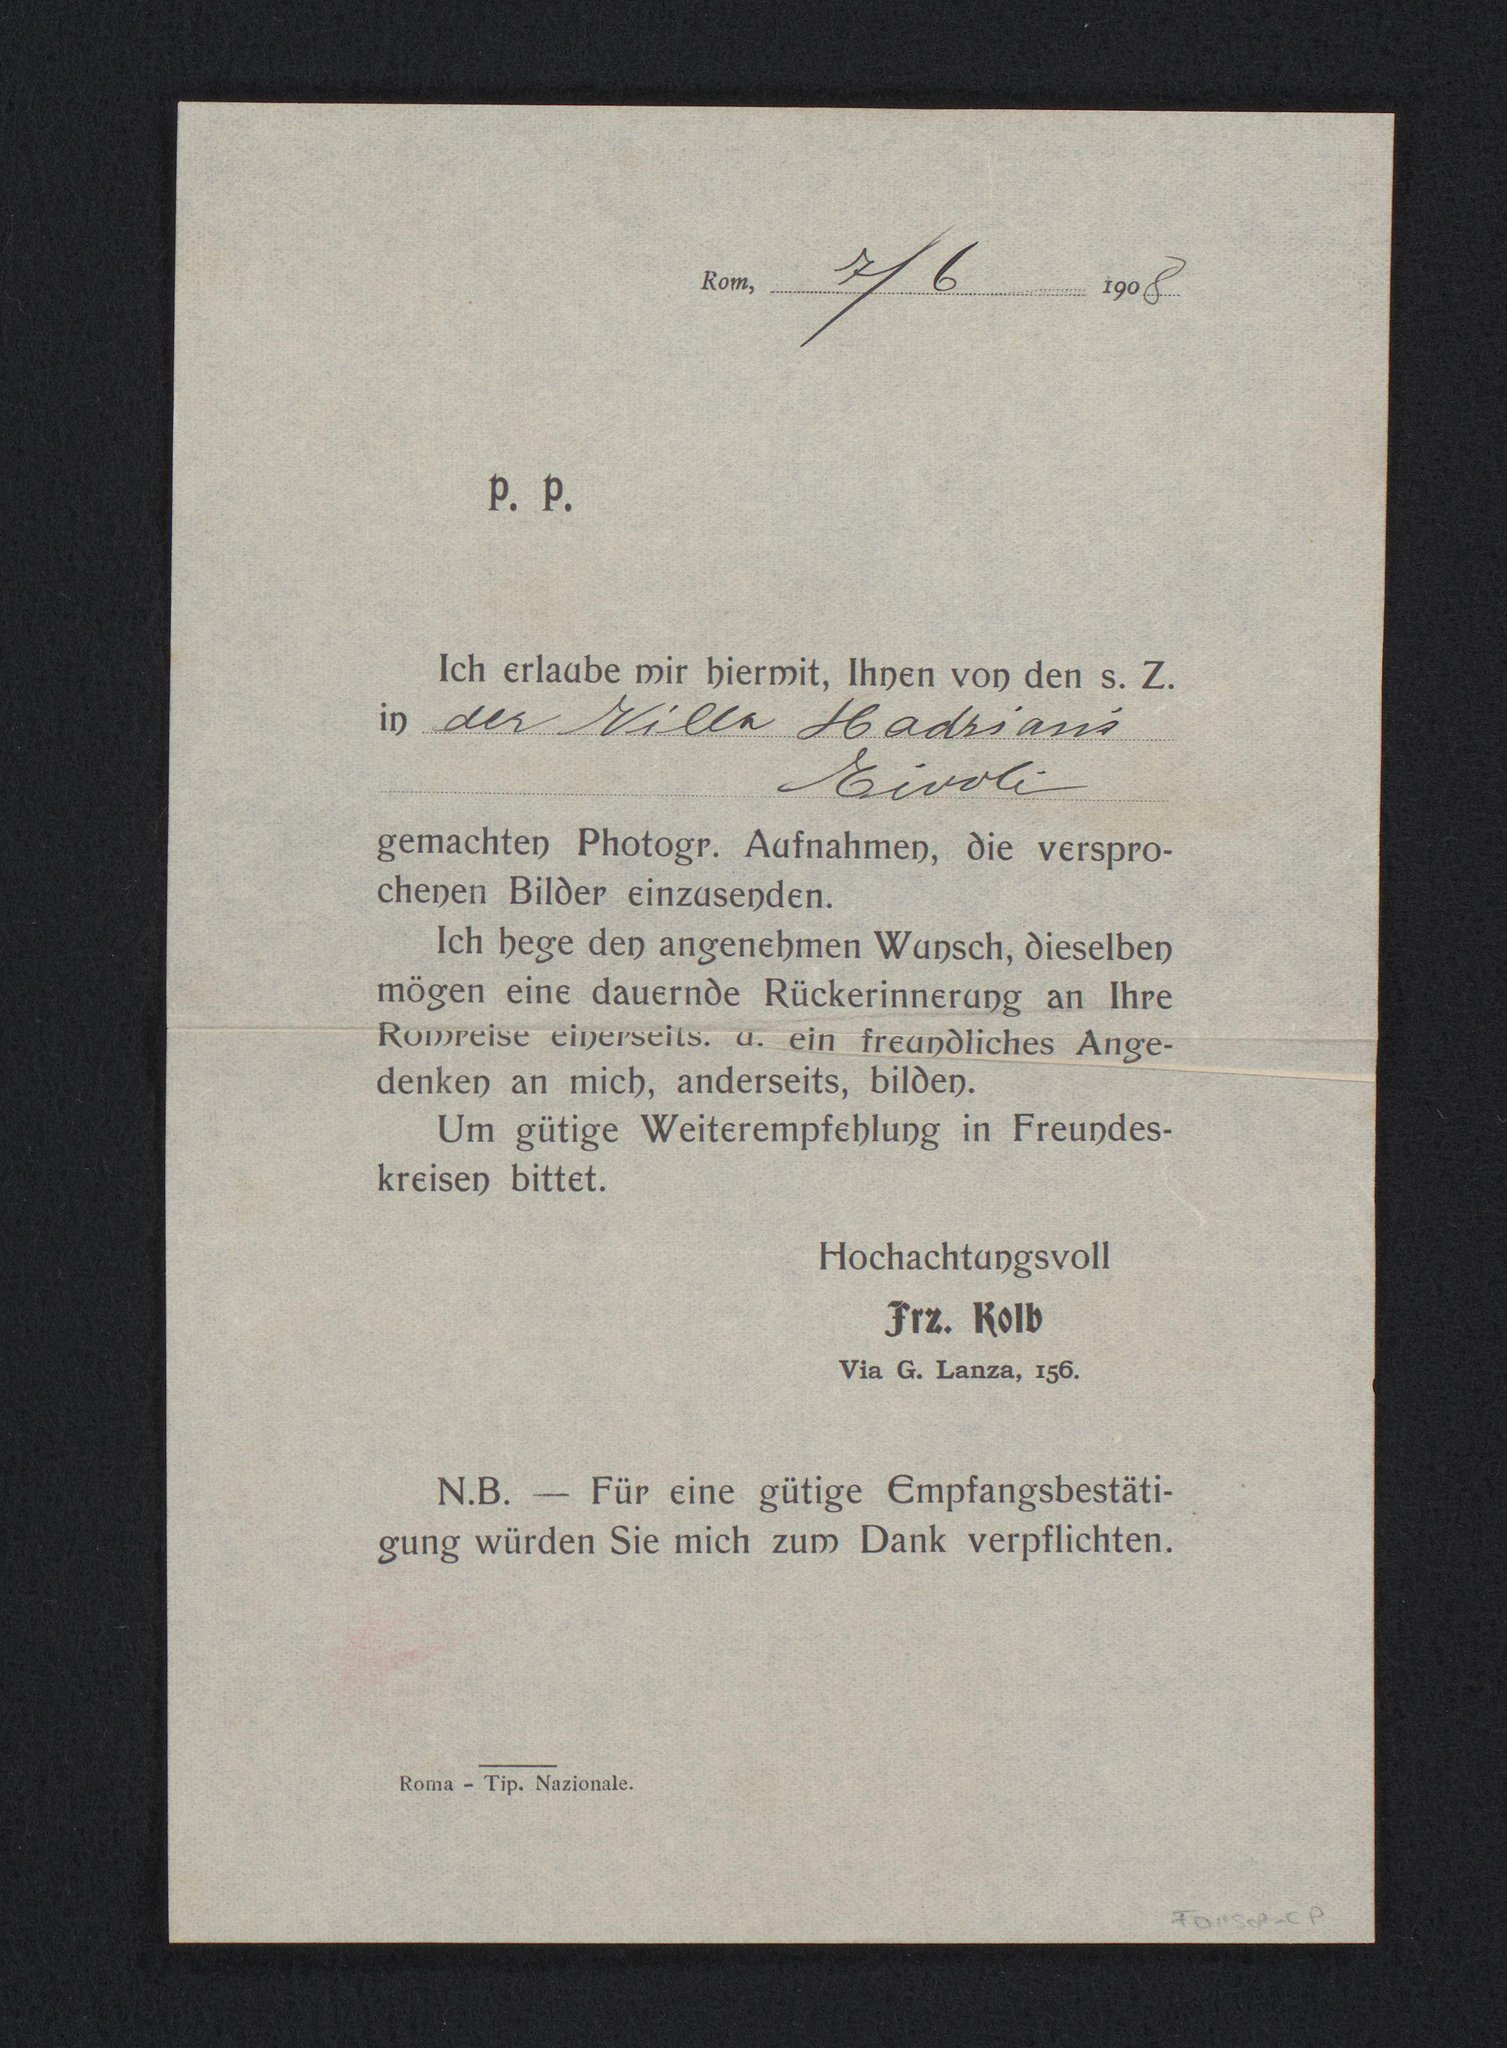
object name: letter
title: Brief van Franz Kolb met een beschrijving voor een bestelling van foto's van de Villa Adriana te Tivoli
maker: franz kolb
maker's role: fotograaf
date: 1908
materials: paper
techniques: printing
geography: rome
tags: printing ~ film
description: Onderdeel van Fotoalbum met opnames van bezienswaardigheden en kunstwerken in Italië.